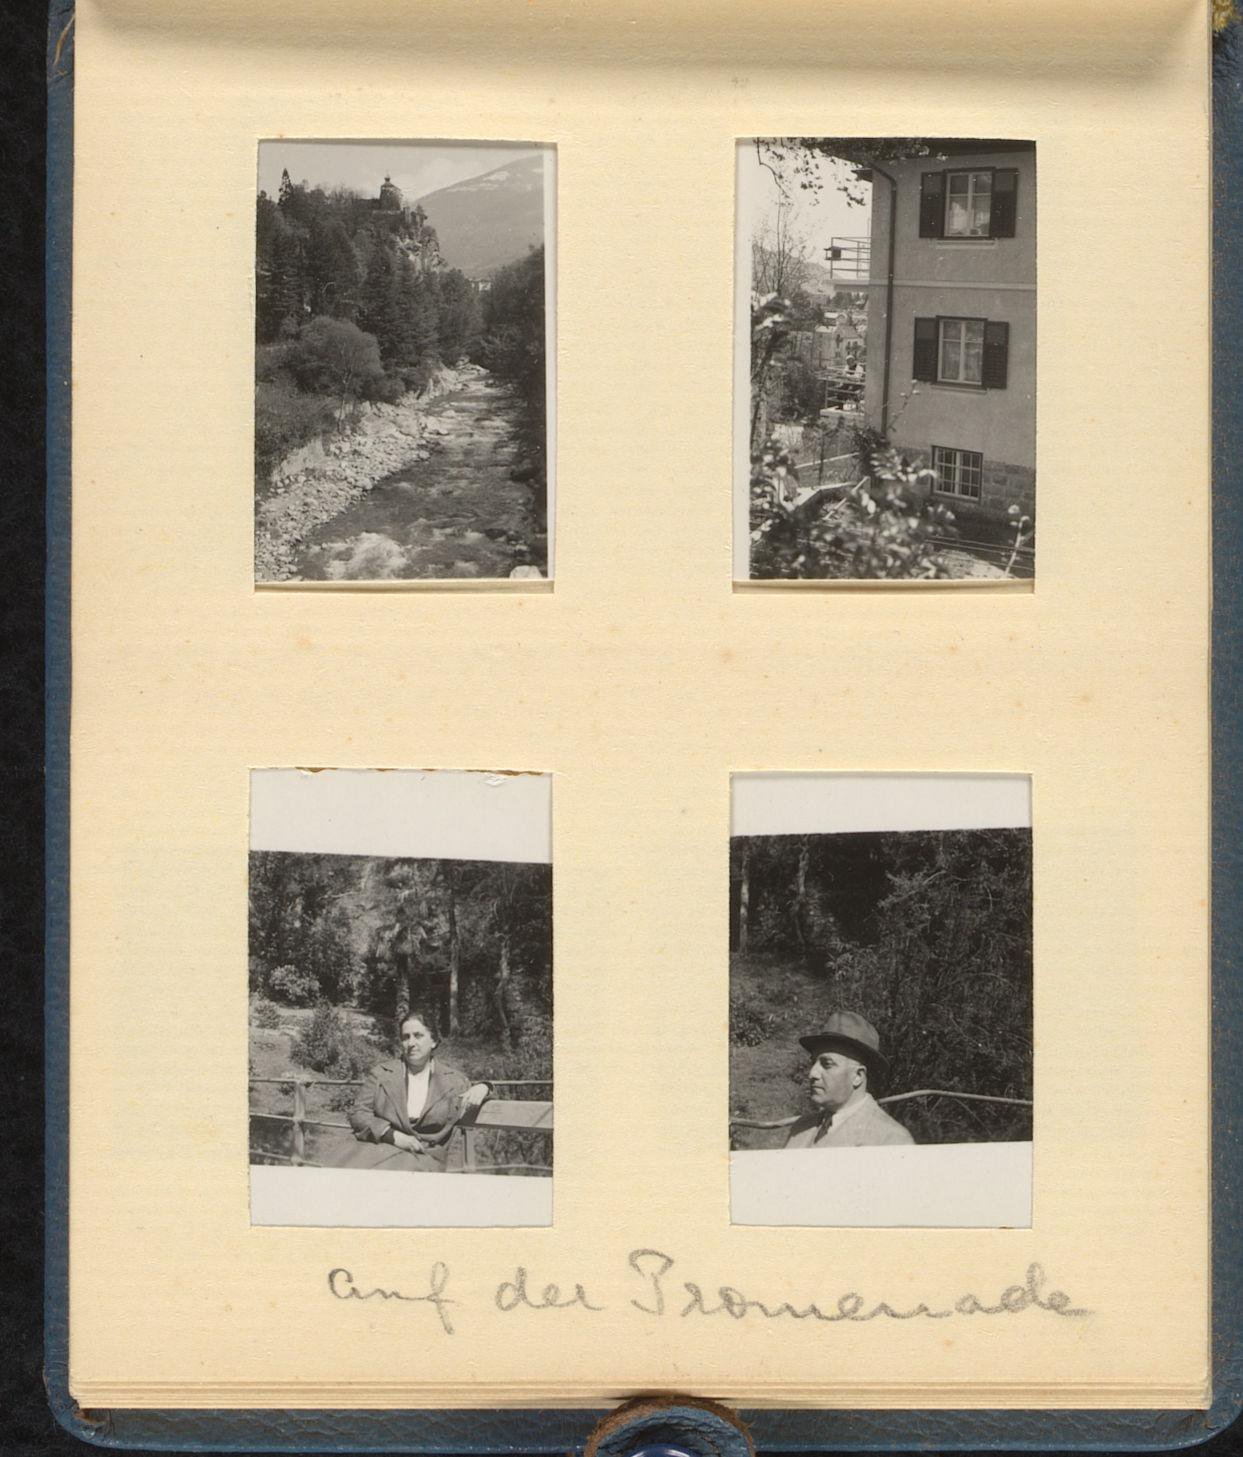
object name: photograph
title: Eugen Wachenheimer en zijn echtgenote Else Wachenheimer-Moos op de promenade van Merano, april-mei 1936, Italië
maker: else wachenheimer-moos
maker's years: 1895-1944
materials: paper, photographic support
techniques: gelatin silver print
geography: merano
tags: eugen wachenheimer, else wachenheimer-moos, the family travelling, on holiday, mountain-range, snow peaks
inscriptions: inscription: ‘auf der Promenade’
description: Albumblad bevat vier foto's. Met foto's van Else Wachenheimer-Moos (links) en Eugen Wachenheimer (rechts). Uit klein formaat fotoalbum, blauw lederen omslag met drukknopsluiting. Met foto's in klein formaat.